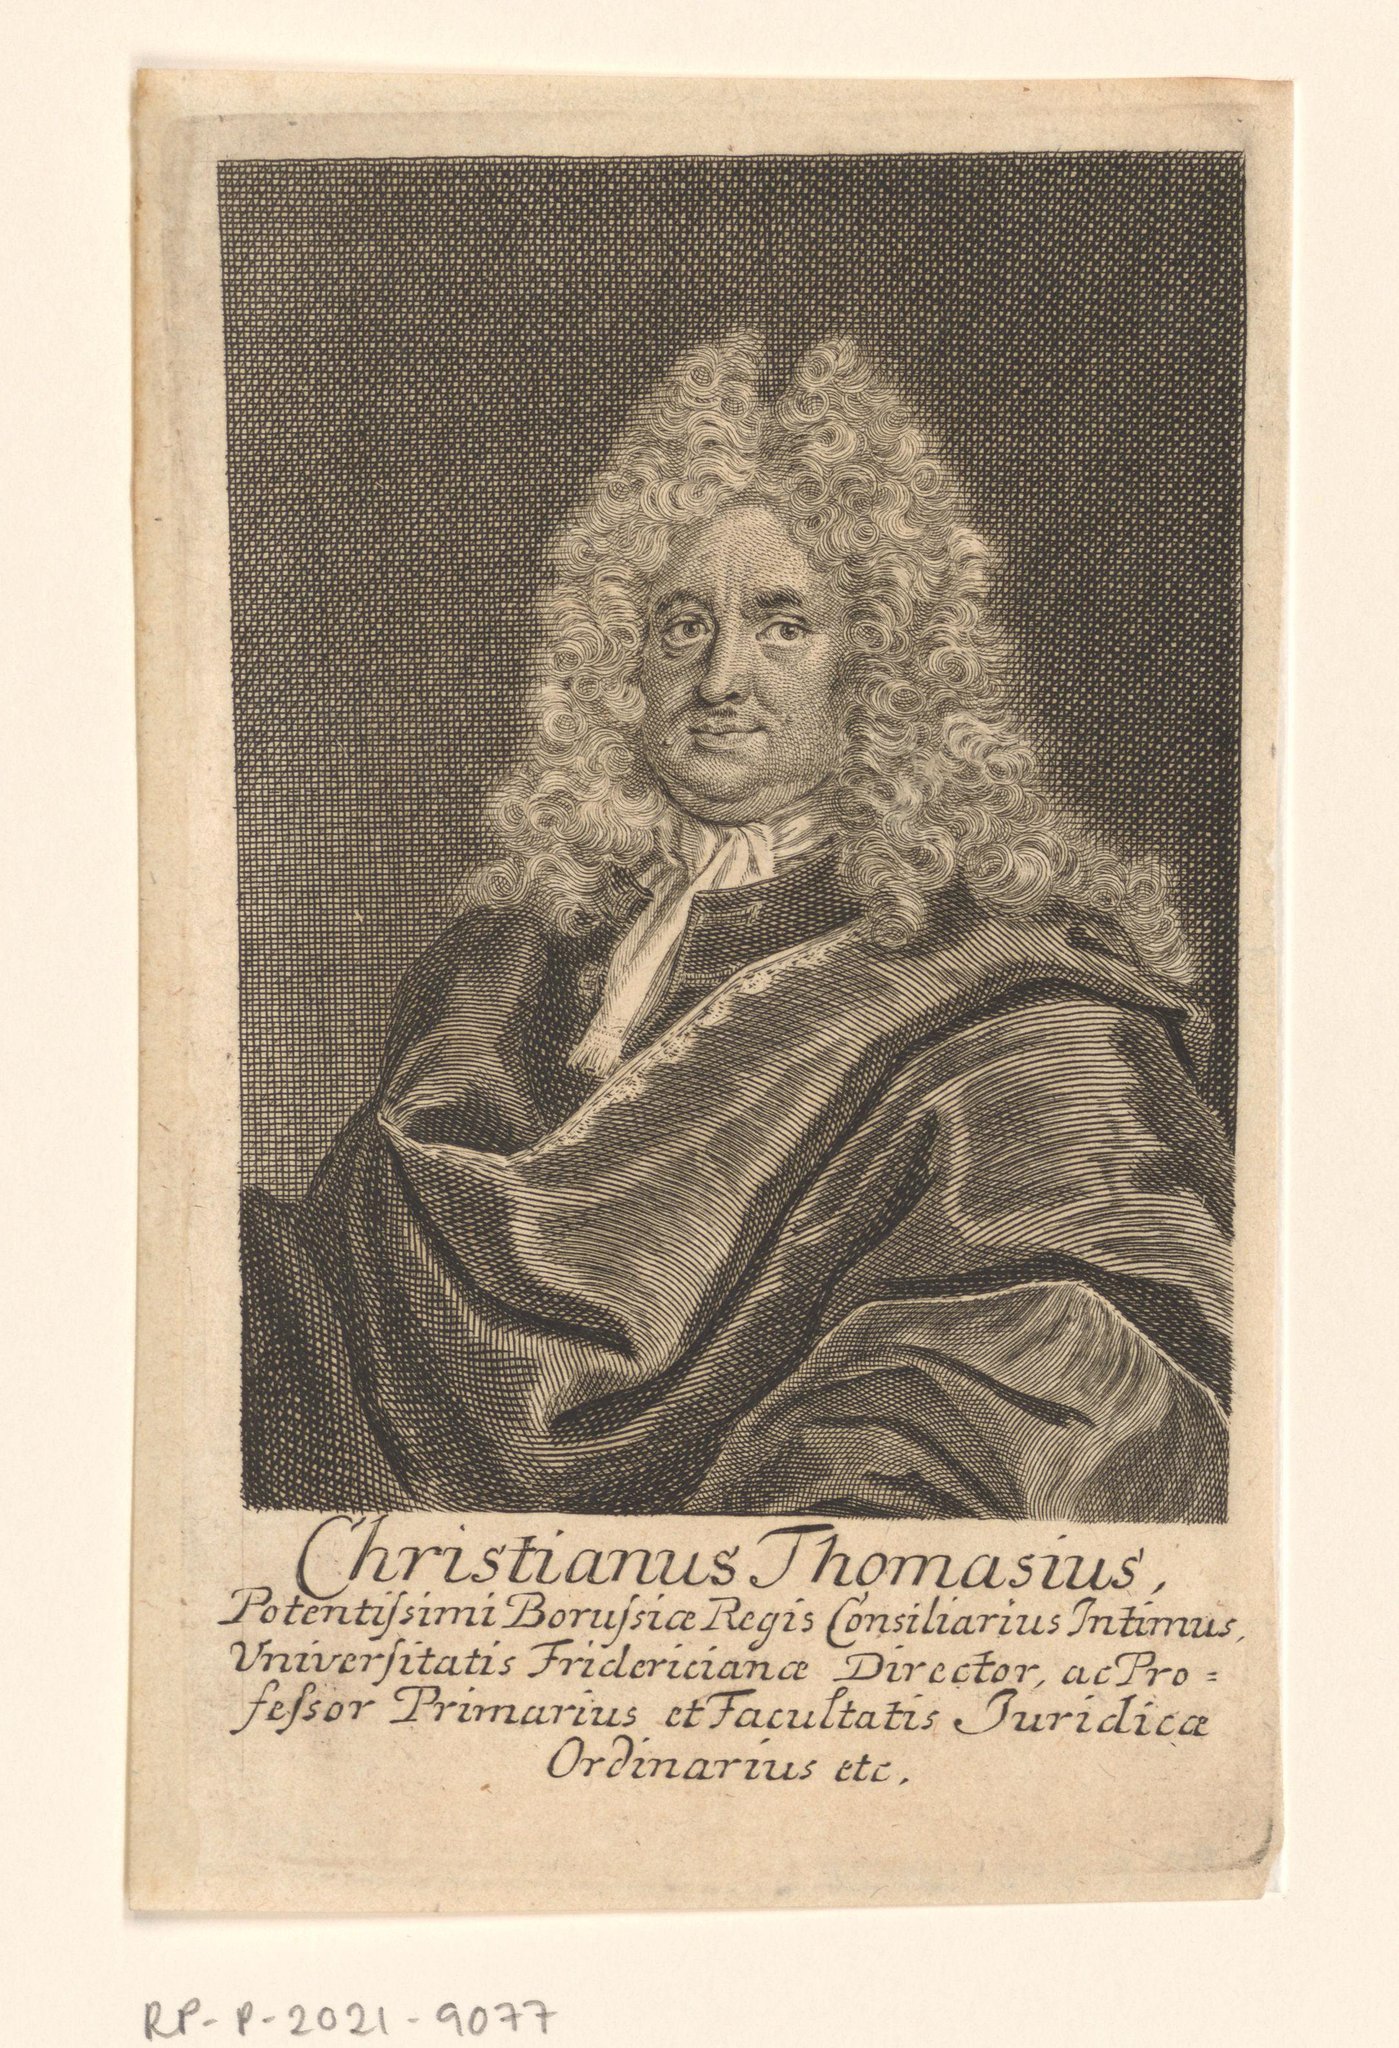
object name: book illustration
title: Portret van Christian Thomasius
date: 1713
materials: paper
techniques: engraving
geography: leipzig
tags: christian thomasius, scholar, philosopher, historical persons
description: Prent uit: Deutsche acta eruditorum. Leipzig: Johann Friedrich en Johann Gottlieb Gleditsch, 1713, dl. 8.